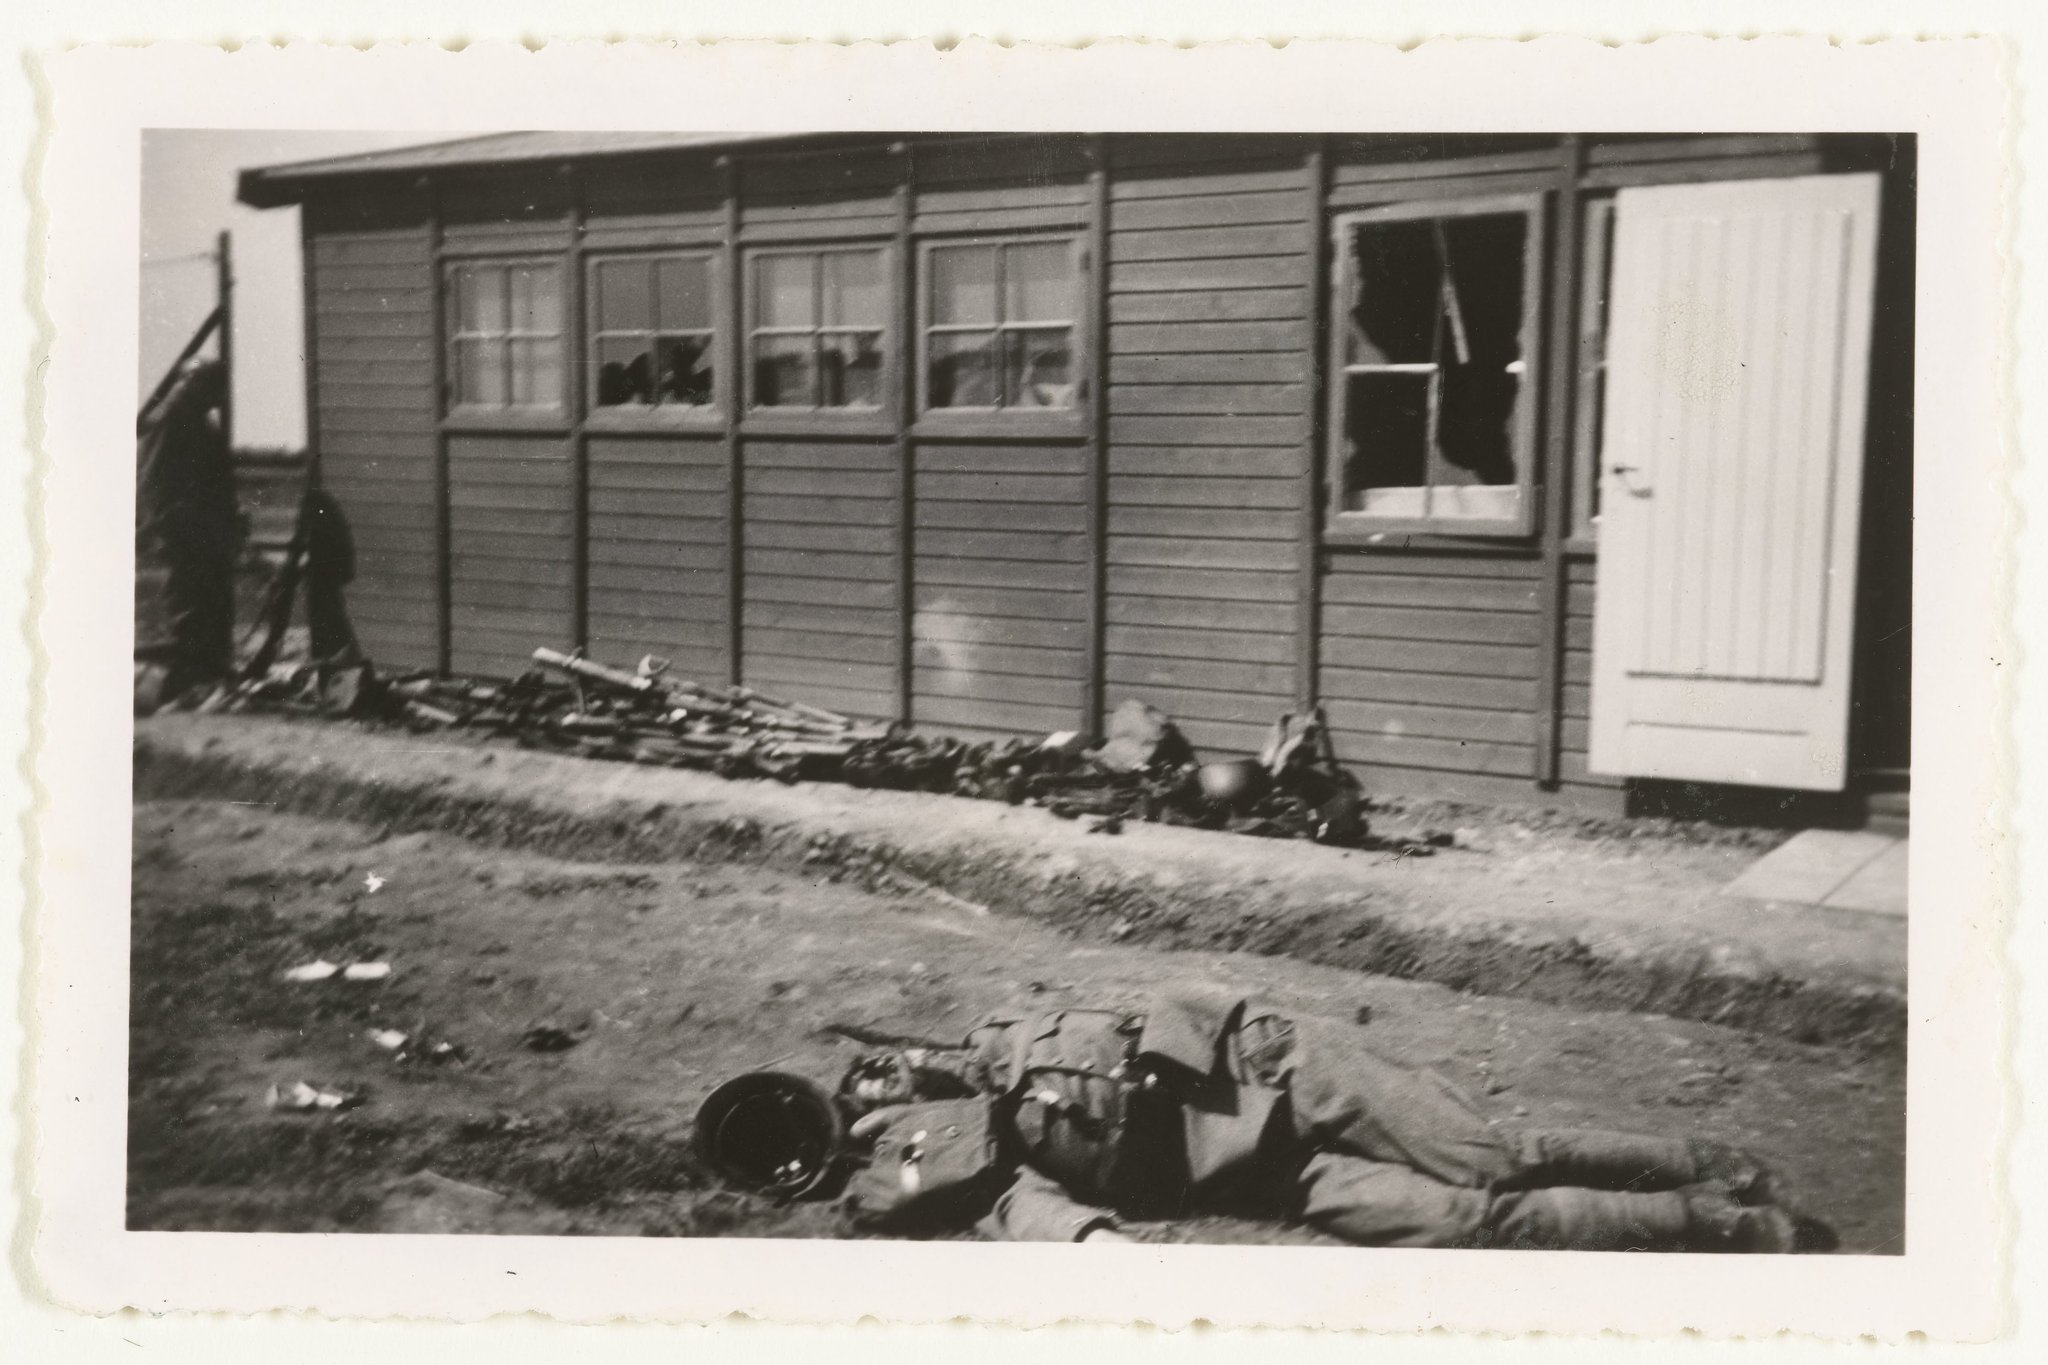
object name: photograph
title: Dode Nederlandse soldaat voor een barak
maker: Anonymous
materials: photographic support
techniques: gelatin silver print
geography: netherlands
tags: violent death, being killed; being mishandled and maltreated; seeking death, the defeated (after the battle), netherlands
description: Een dode Nederlandse soldaat ligt voor een barak waar door de Nederlanders achtergelaten wapens liggen